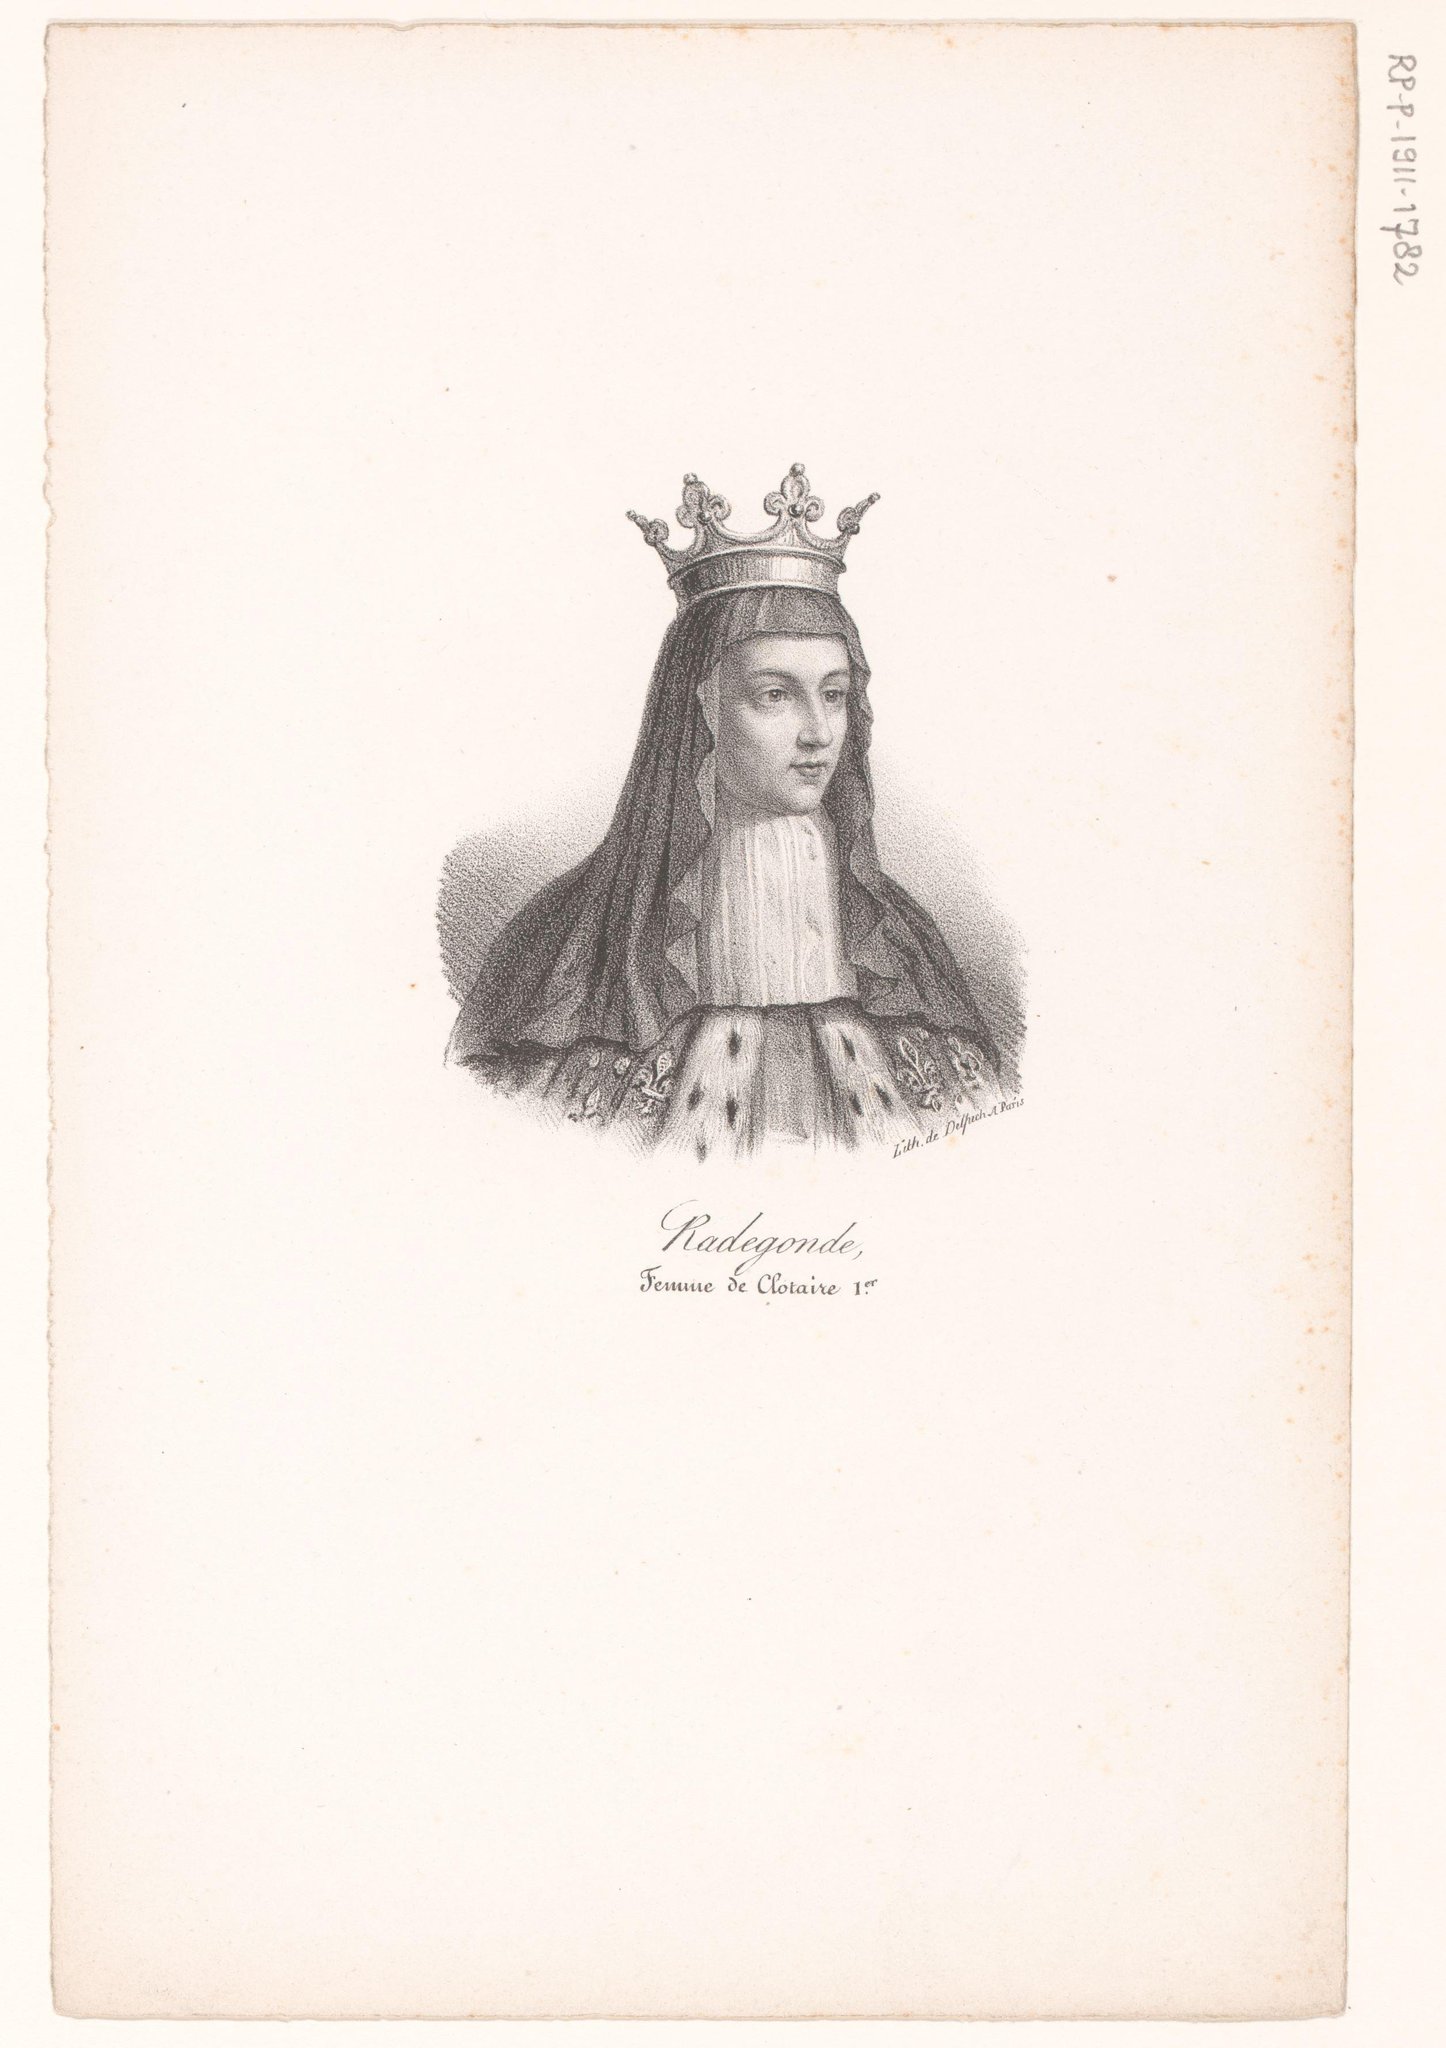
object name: print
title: Radegonde, femme de Clotaire 1er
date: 1818-1842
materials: paper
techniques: lithograph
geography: paris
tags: historical persons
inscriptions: collector's mark: Lugt 2228a